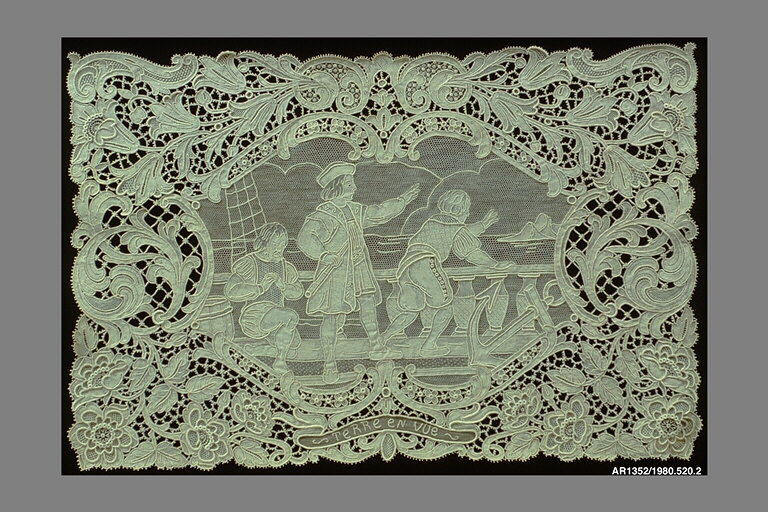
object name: mat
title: Mat (from a set of table linens)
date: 1867-1900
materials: linen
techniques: lace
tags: men,flowers